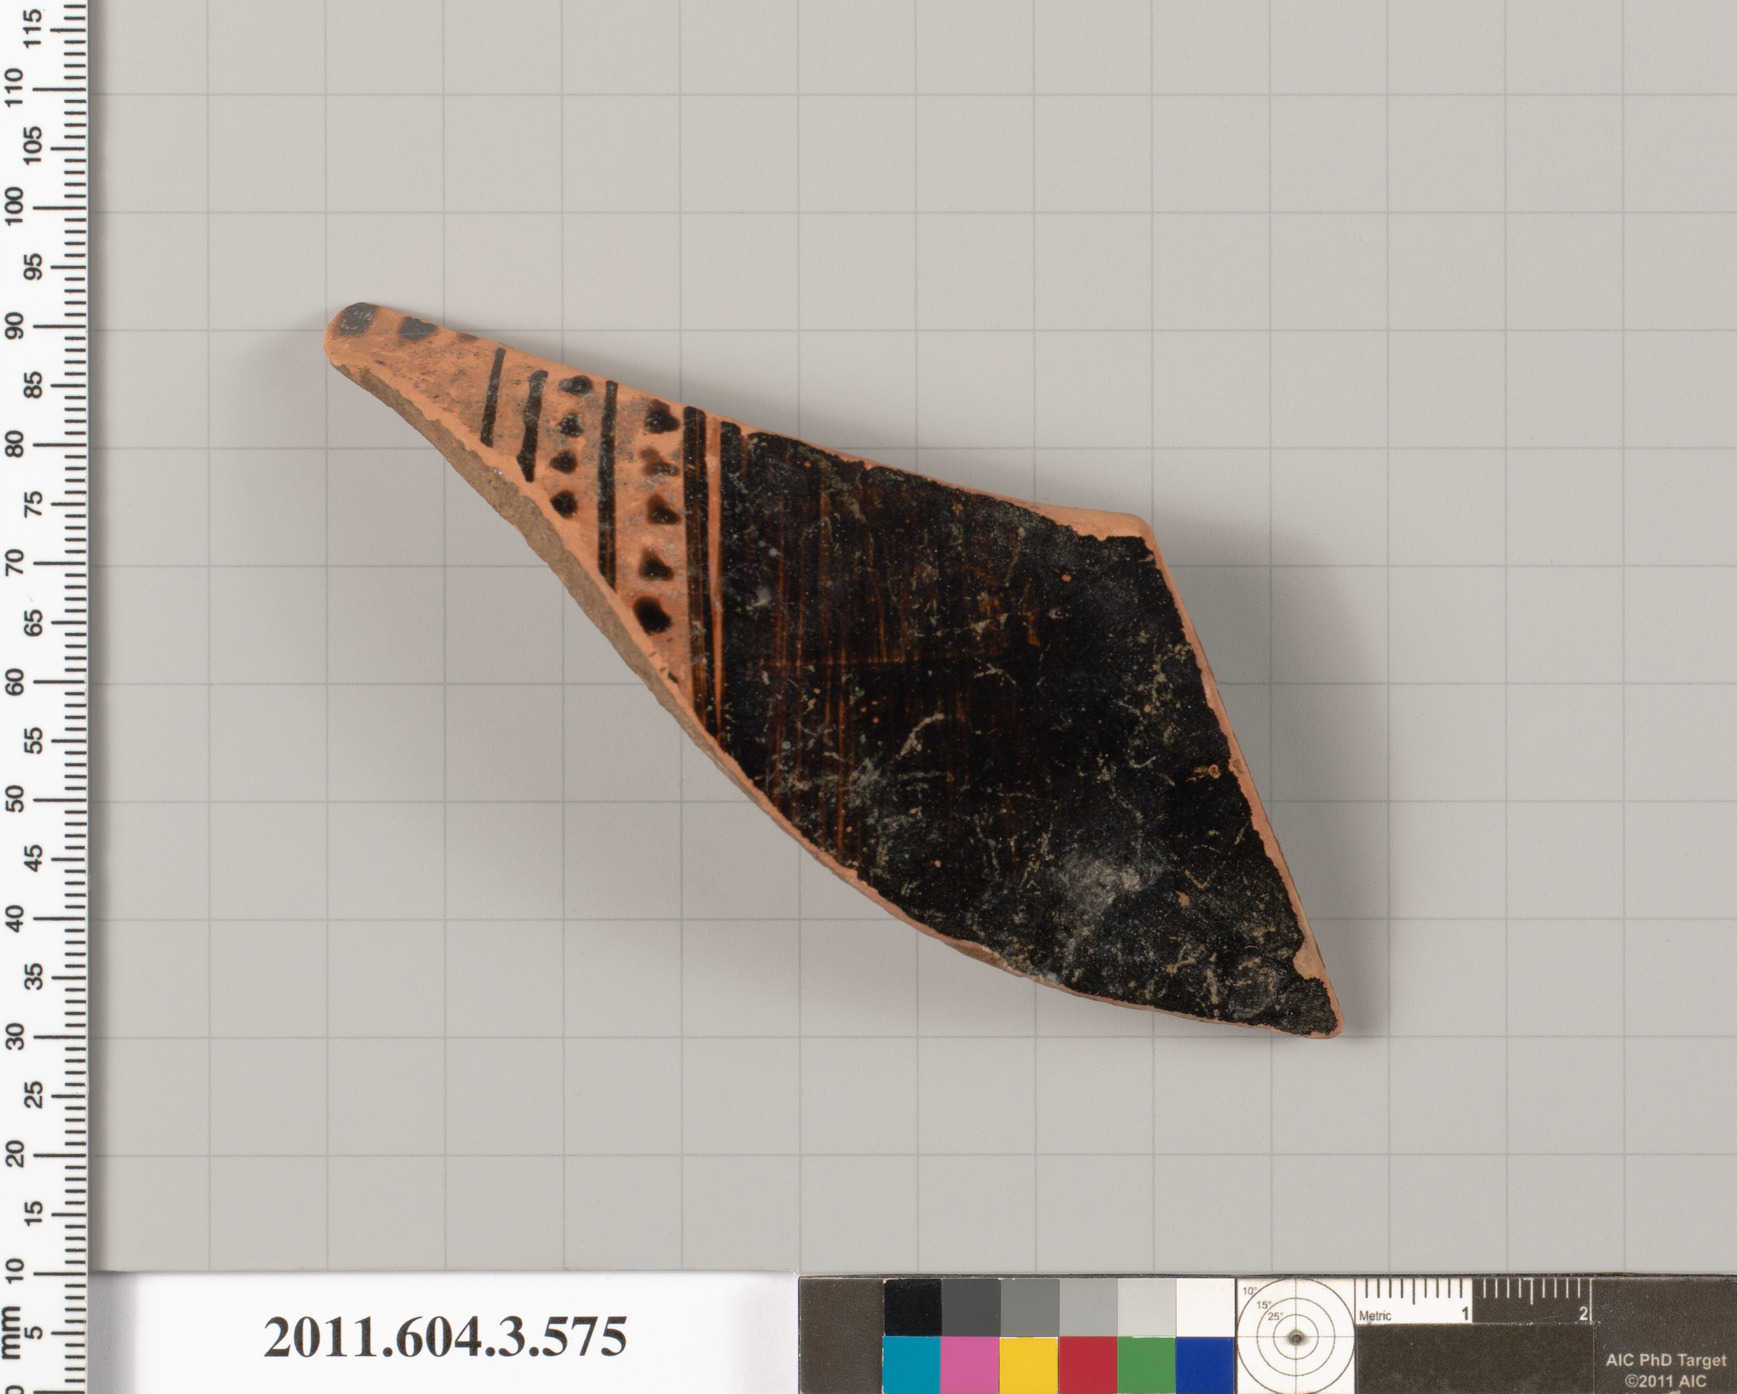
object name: column krater fragment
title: Terracotta fragment of a column-krater (bowl for mixing wine and water)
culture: greek, attic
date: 534-501 BCE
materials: terracotta